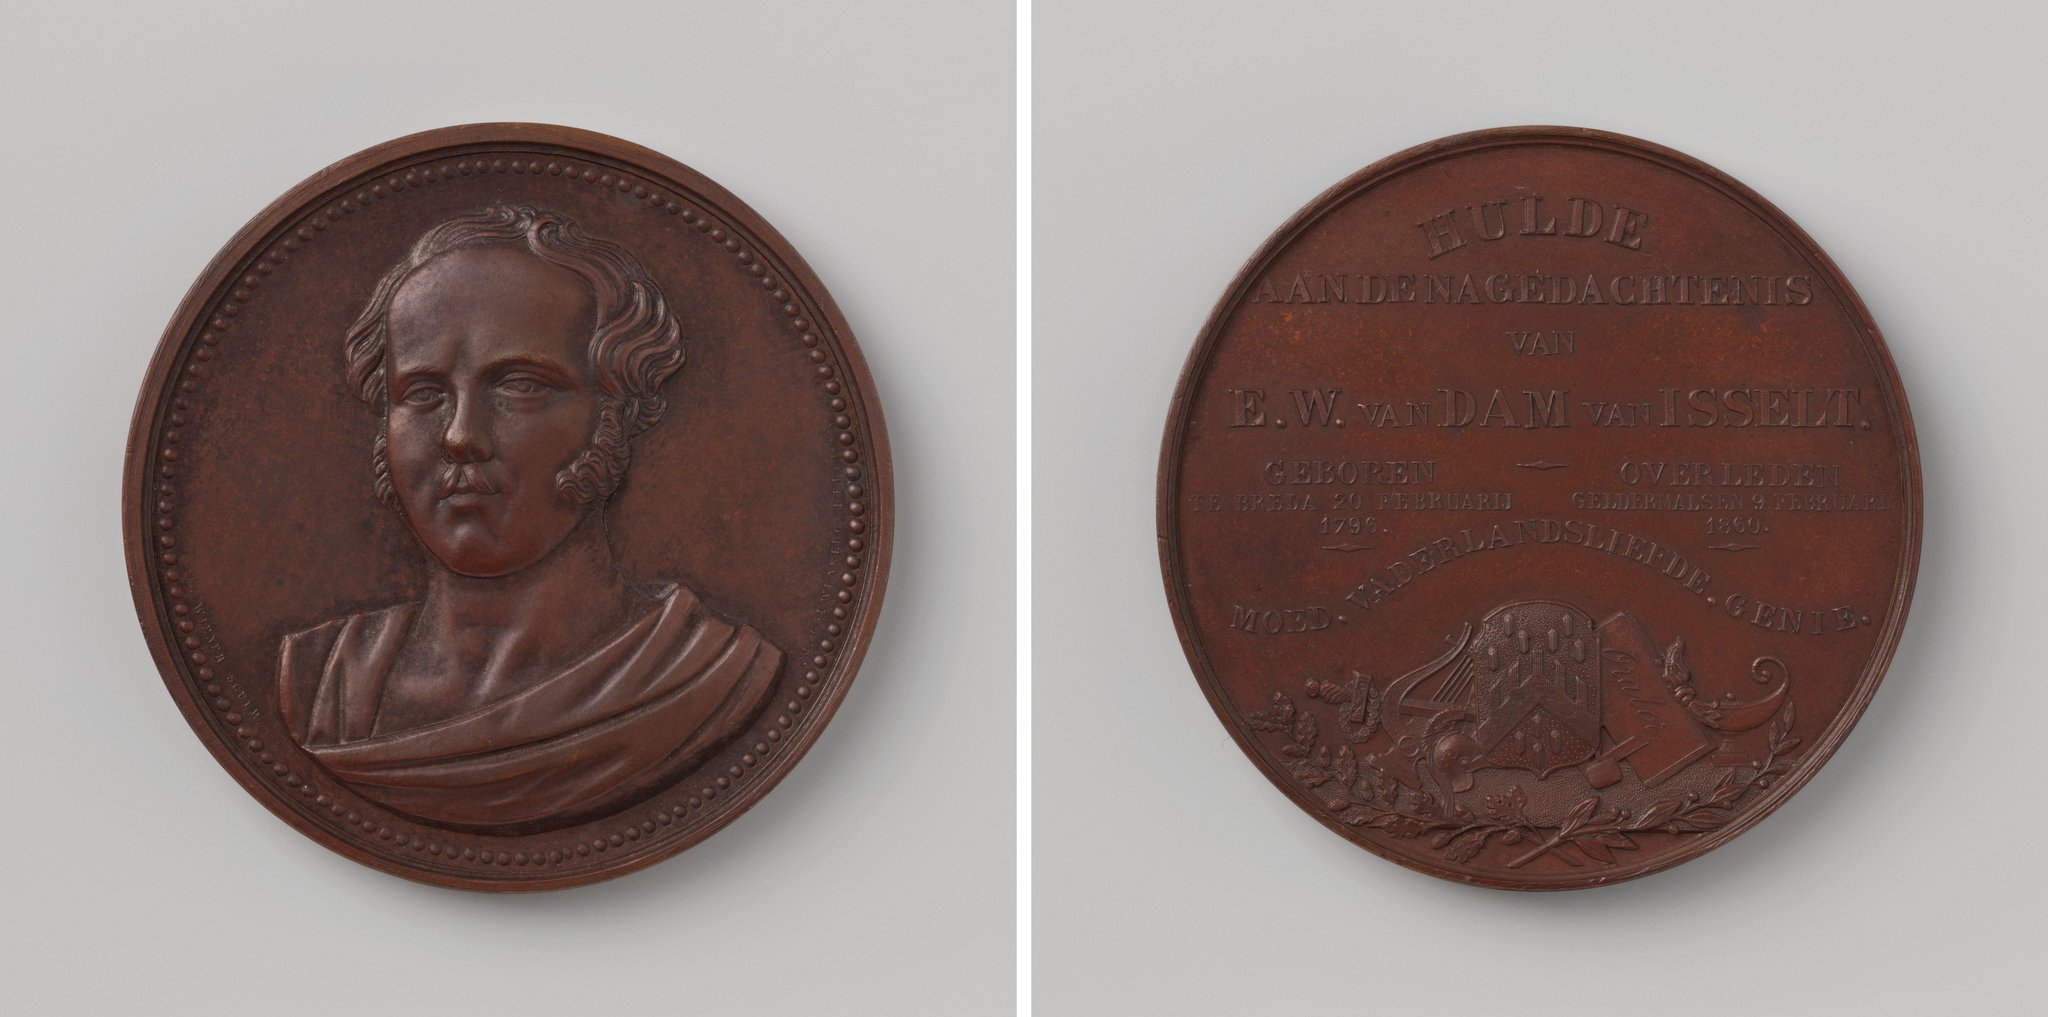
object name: history medal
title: Overlijden van Edmond Willem van Dam van Isselt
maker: karel wiener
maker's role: medailleur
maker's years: 1831-1888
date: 1860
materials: bronze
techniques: striking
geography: the hague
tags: breda, geldermalsen, dichter, schrijver, majoor, edmond willem van dam van isselt, tweede kamer der staten-generaal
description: Bronzen penning. Voorzijde: borststuk man. Keerzijde: opschrift boven wapenschild, zwaard waar lauwerkrans aan hangt, lier, helm, vrijmetselaarshamer, winkelhaak en bundel met opschrift, rustend op eike- en olijftak.